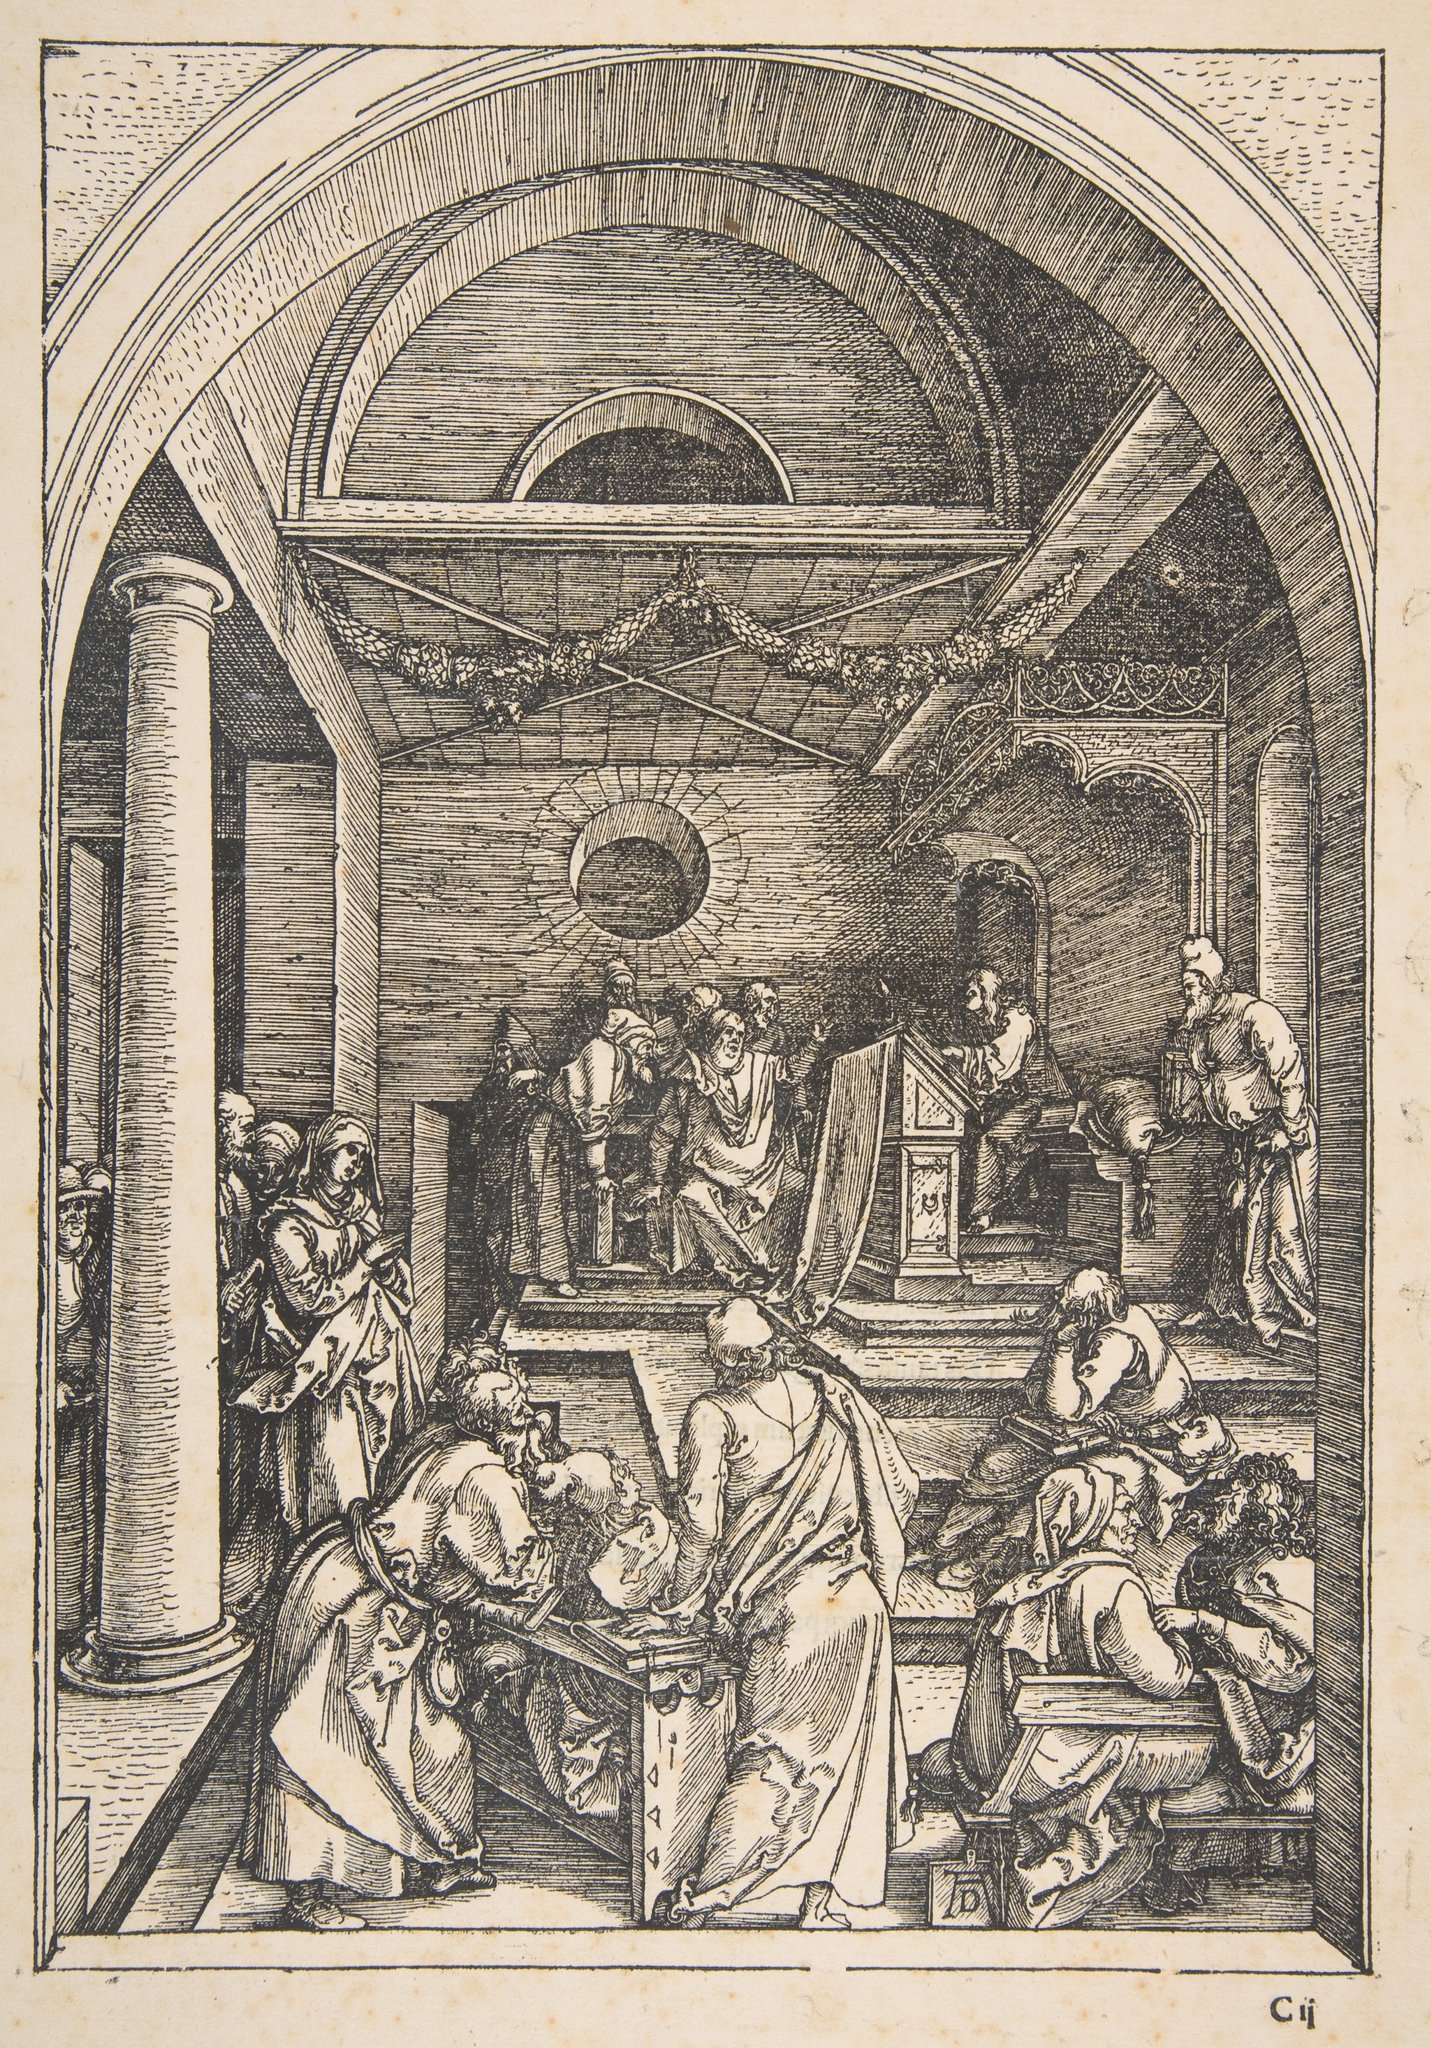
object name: print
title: Christ among the Doctors, from "The Life of the Virgin"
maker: albrecht dürer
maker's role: artist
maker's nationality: german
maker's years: 1471-1528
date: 1511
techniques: woodcut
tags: men,virgin mary,jesus,doctors